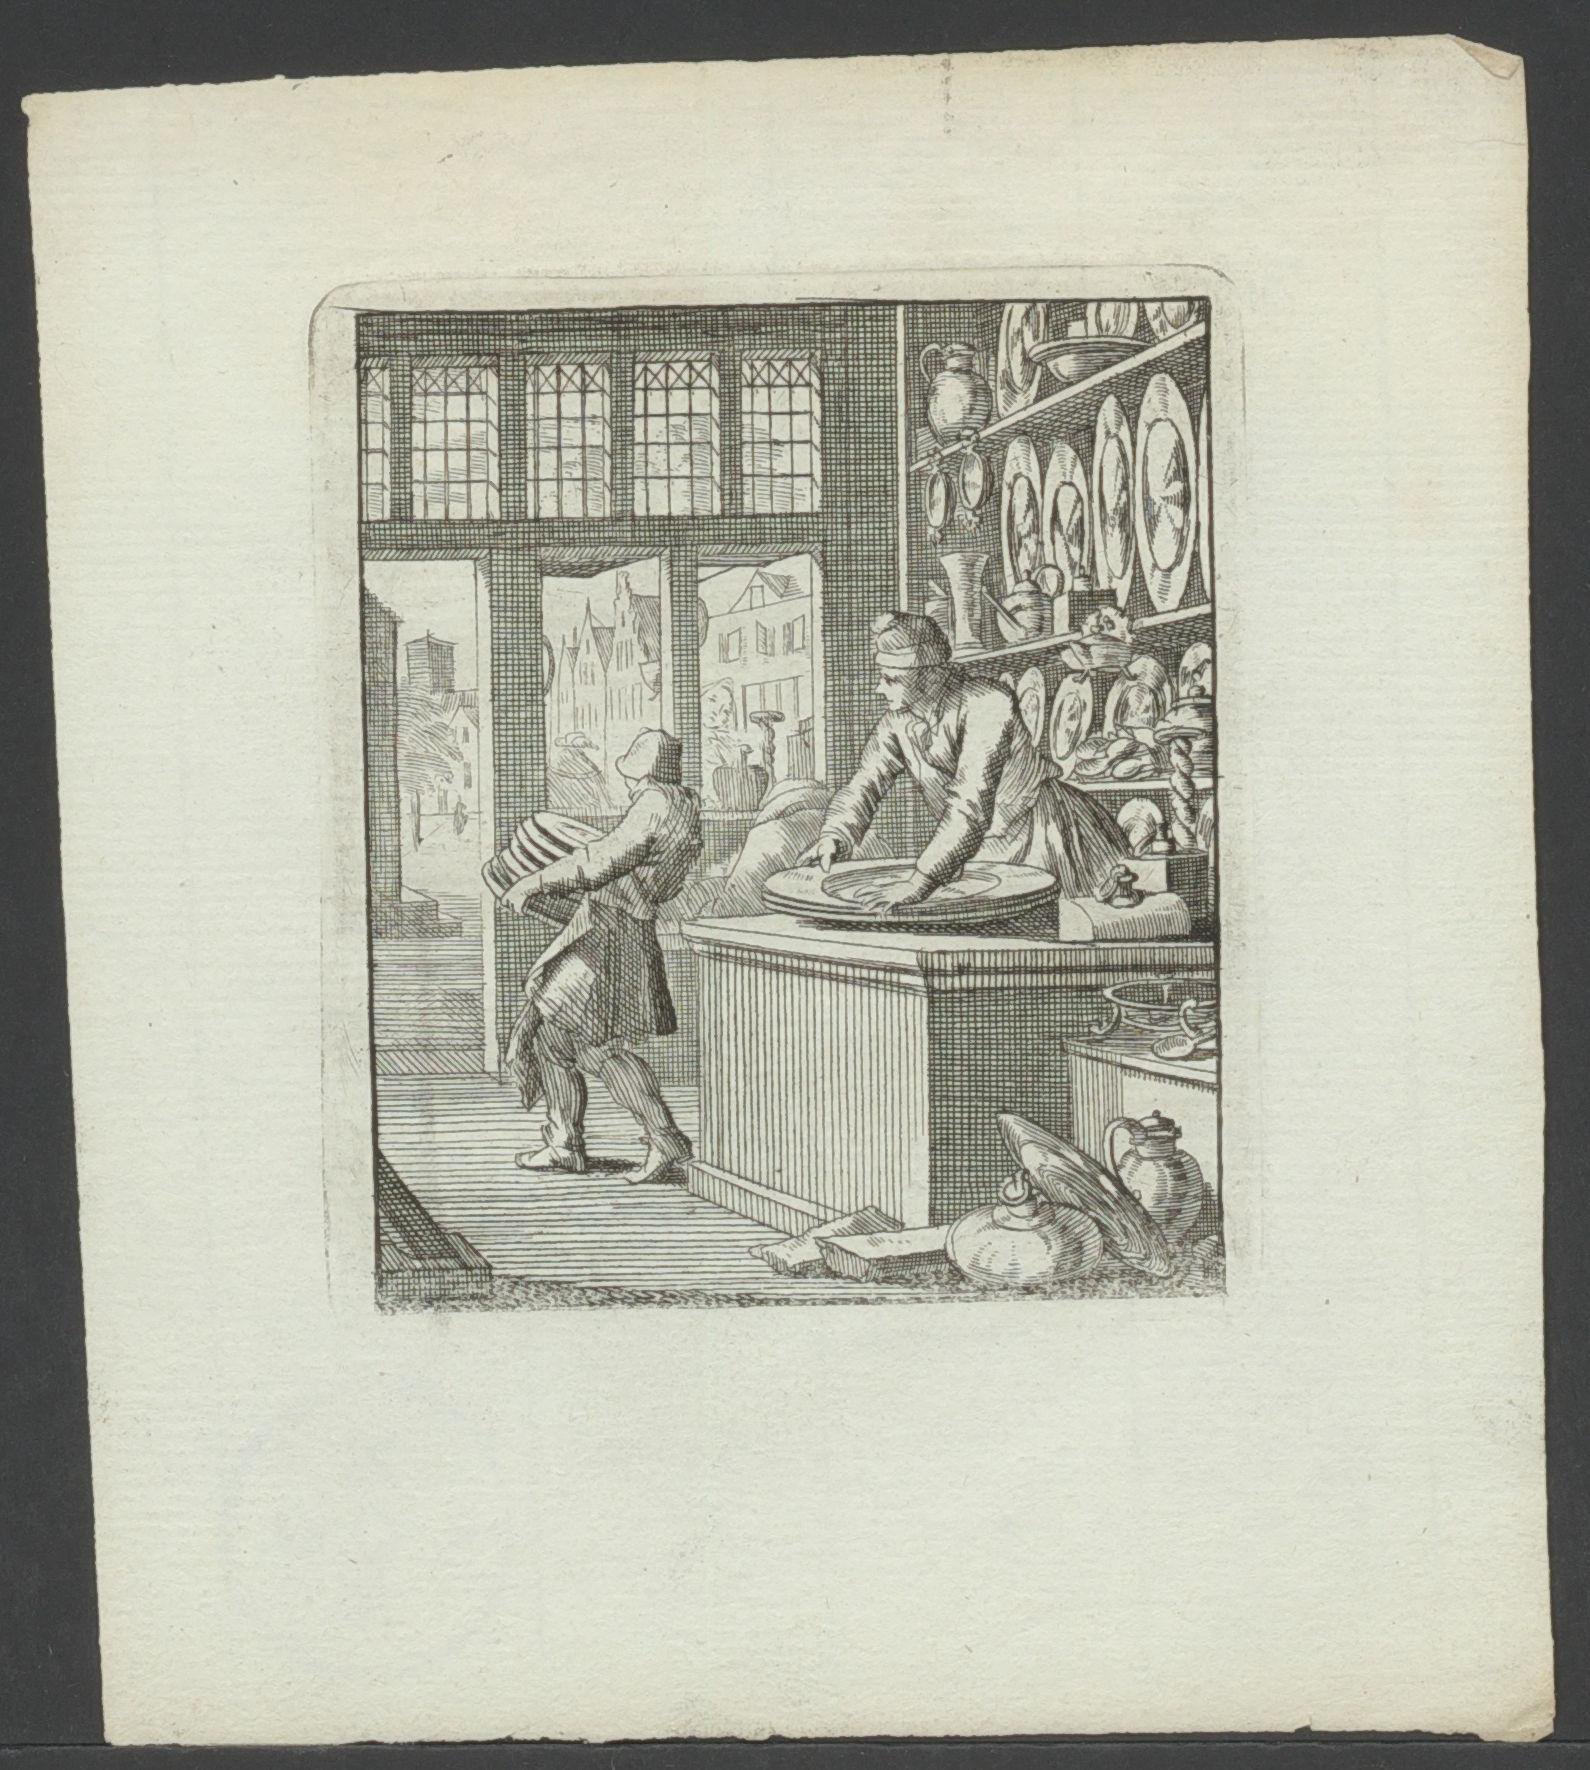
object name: print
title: Tingieter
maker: Anonymous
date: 1694-1799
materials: paper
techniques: engraving, etching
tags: handicrafts, craftsman at work, other handicrafts ~ metal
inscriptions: collector's mark: Lugt 1641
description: Onderwerpsrubrieken binnen de Atlas Zeden en Gewoonten: Handel, Nijverheid en Verkeer, Beroep en bedrijf, Complete suites.